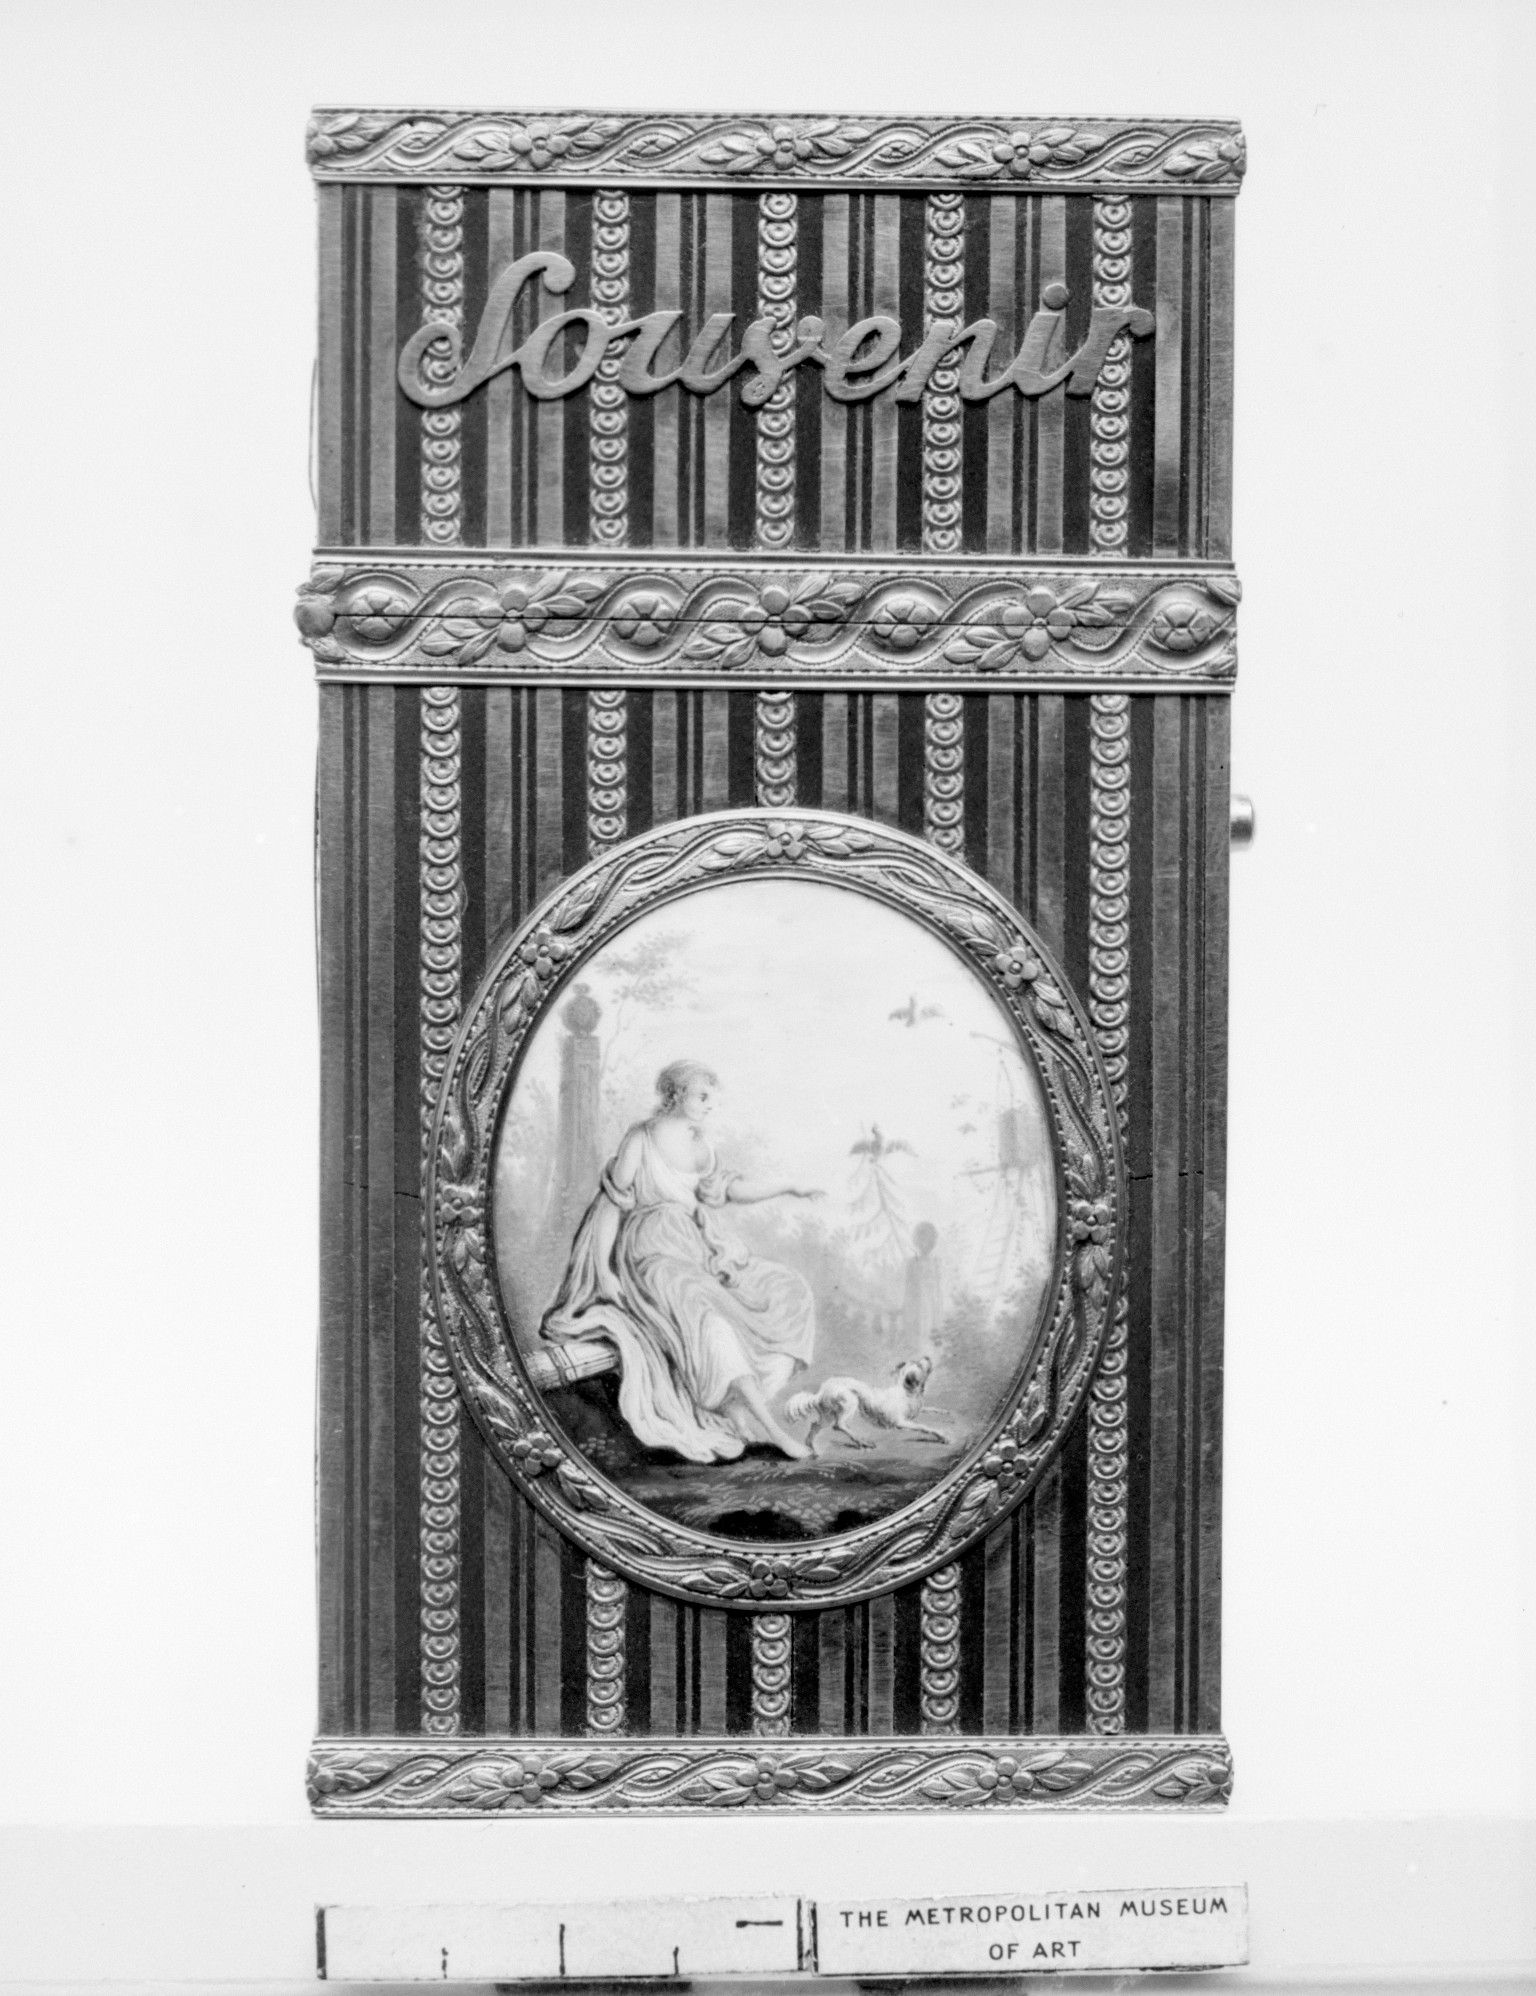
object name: souvenir, painting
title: Souvenir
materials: enamel, gold, ivory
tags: birds,women,dogs,flowers